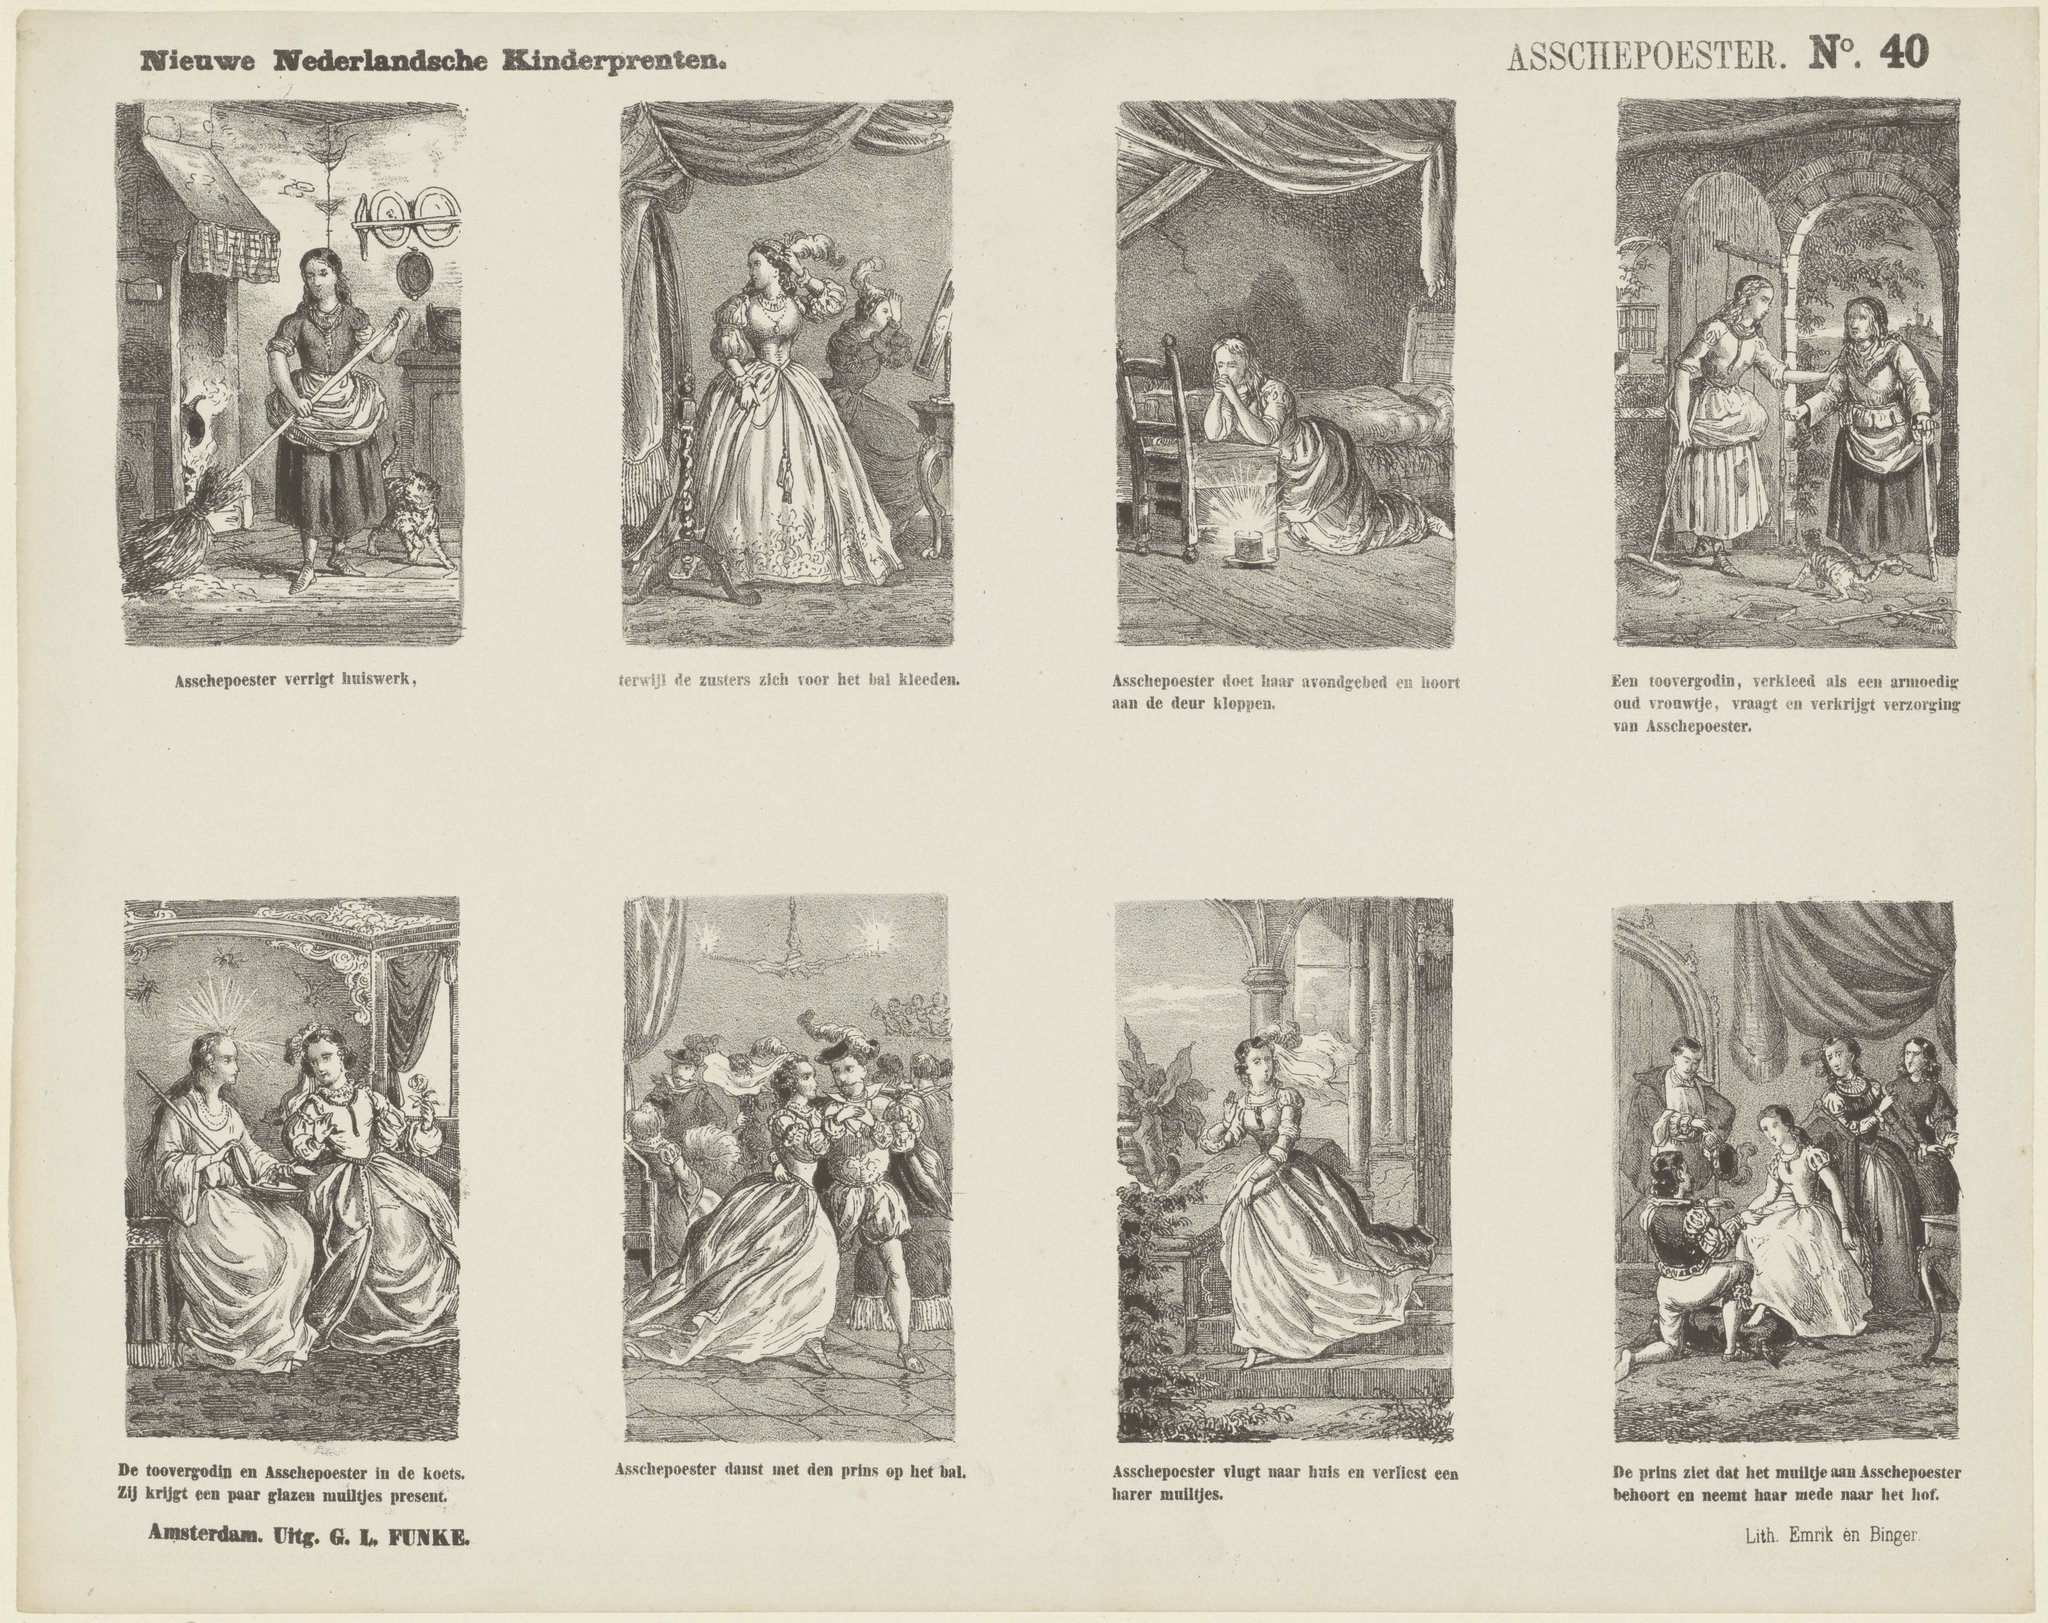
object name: popular print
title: Asschepoester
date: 1865-1875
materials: paper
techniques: letterpress printing, lithograph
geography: haarlem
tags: tales and fairy tales (with title)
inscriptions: collector's mark: Lugt 2760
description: Blad met 8 voorstellingen uit het sprookje van Assepoester. Onder elke afbeelding een onderschrift. Genummerd rechtsboven: No. 40.